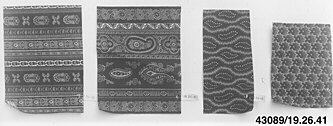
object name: sample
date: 1840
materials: cotton